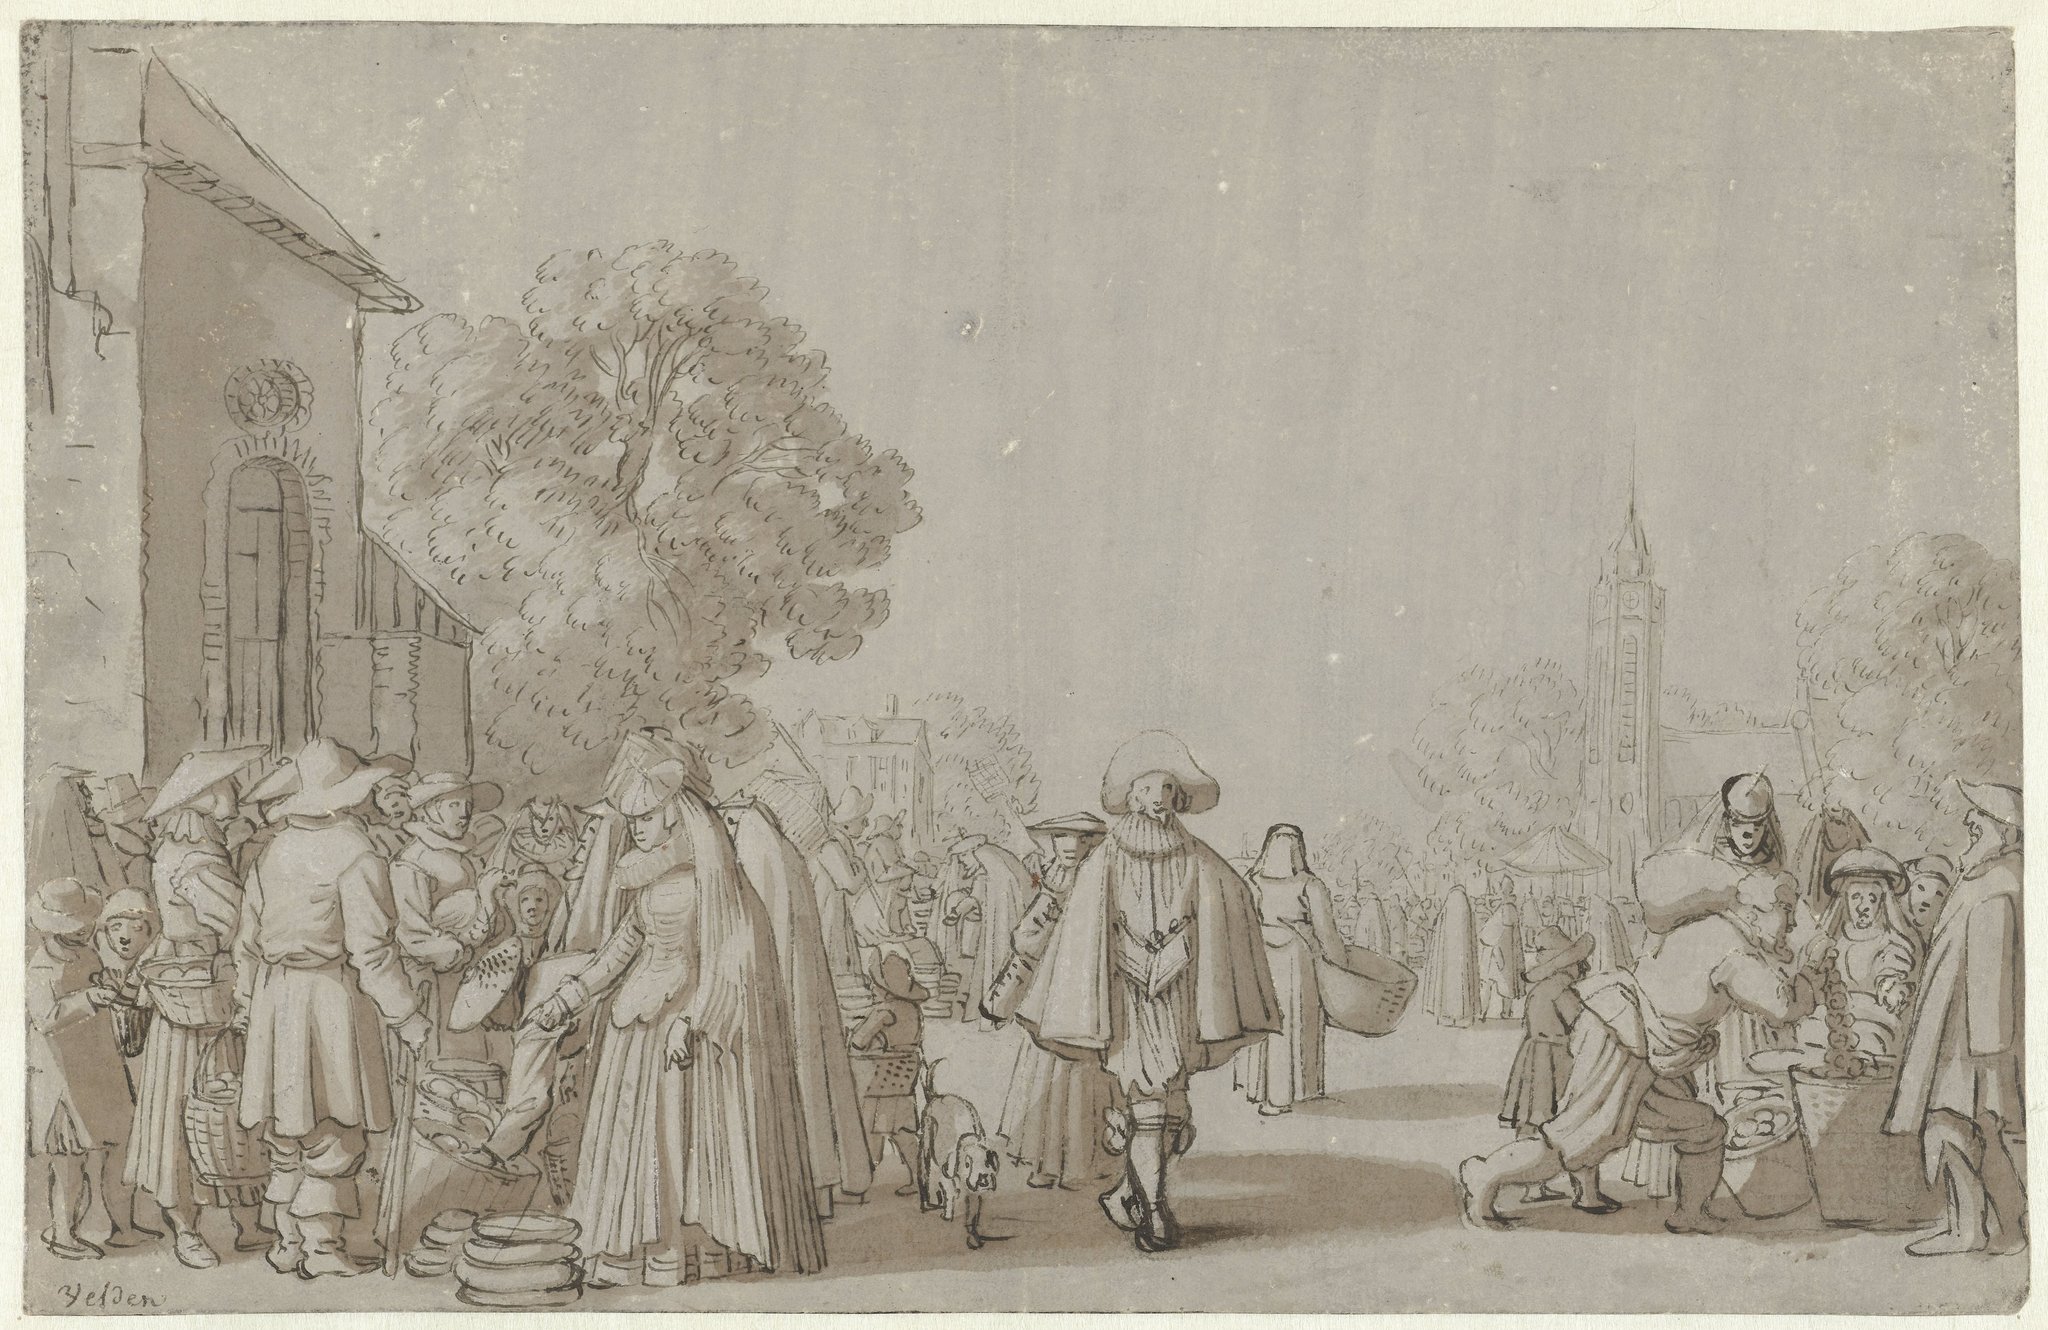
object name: drawing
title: Marktscène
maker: jan van de velde (ii)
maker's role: draughtsman, painter, print maker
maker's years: 1593-1641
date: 1603-1641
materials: ink, paper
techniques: brush, pen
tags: square, place, circus, etc., market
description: Marktscène met figuren op de voorgrond. In het midden een heer met hond. Linksvoor liggen ronde kazen op de grond. De kerk met de hexagonale toren in de achtergrond lijkt op de St. Jacobskerk in Den Haag. Mogelijk een ontwerp voor een prent.